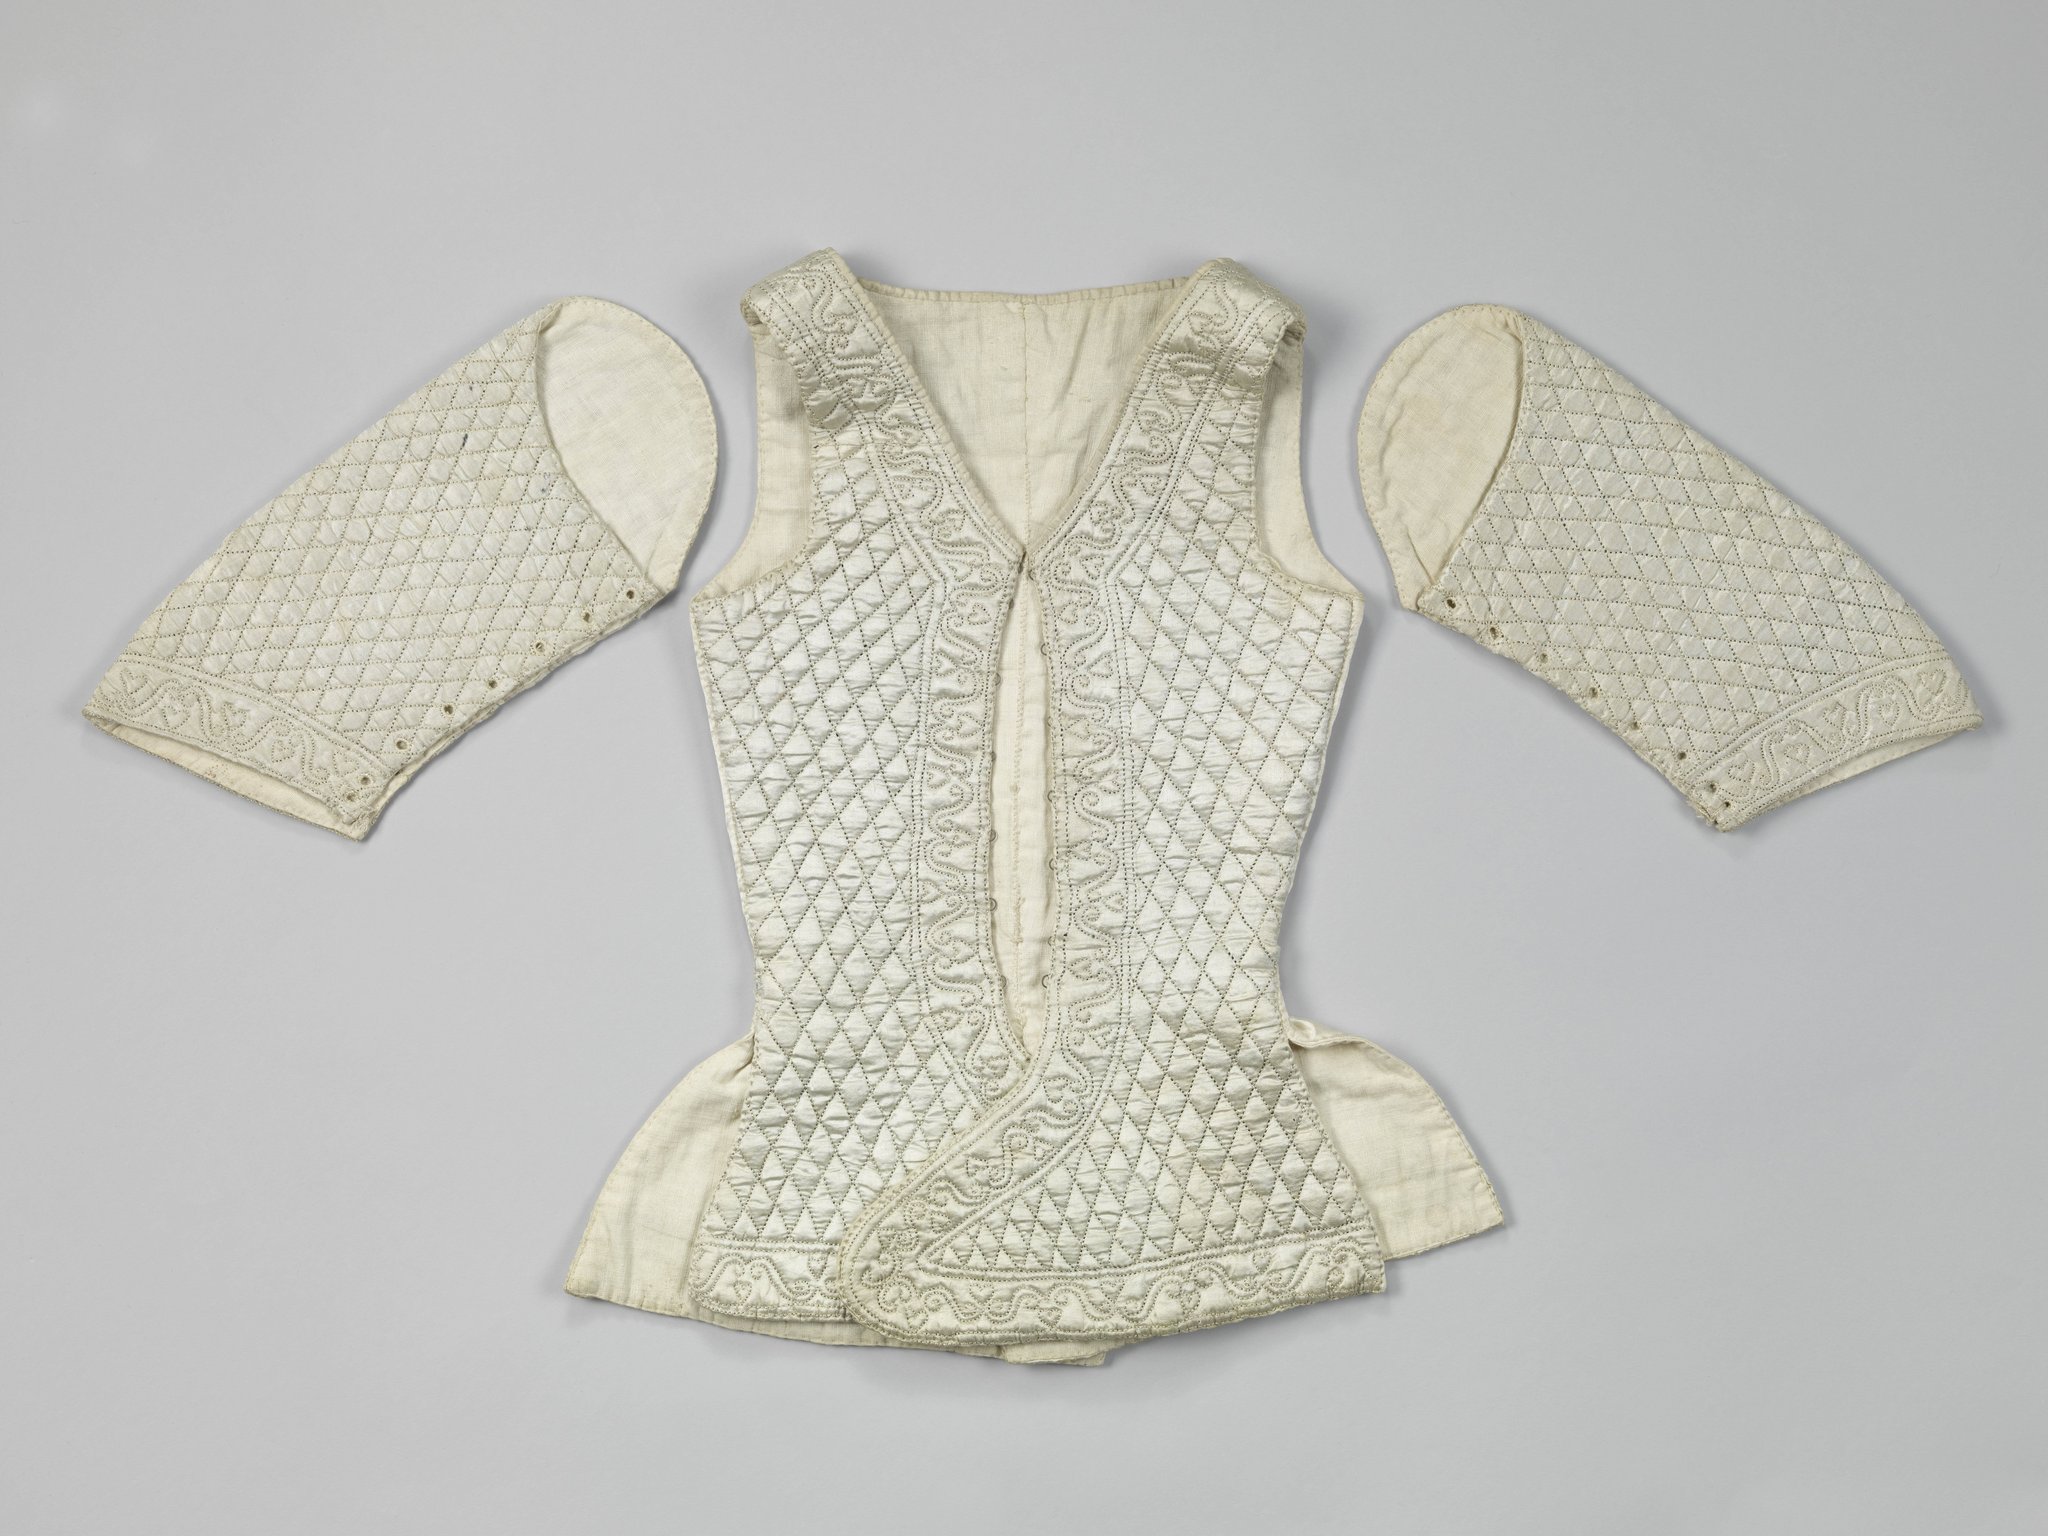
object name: childrenswear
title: Losse mouw van kinderwambuis van gematelasseerde witte satijn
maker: Anonymous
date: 1600-1699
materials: textile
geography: netherlands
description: Losse mouw van kinderwambuis van gematelasseerde witte satijn. Sportkleding (?).